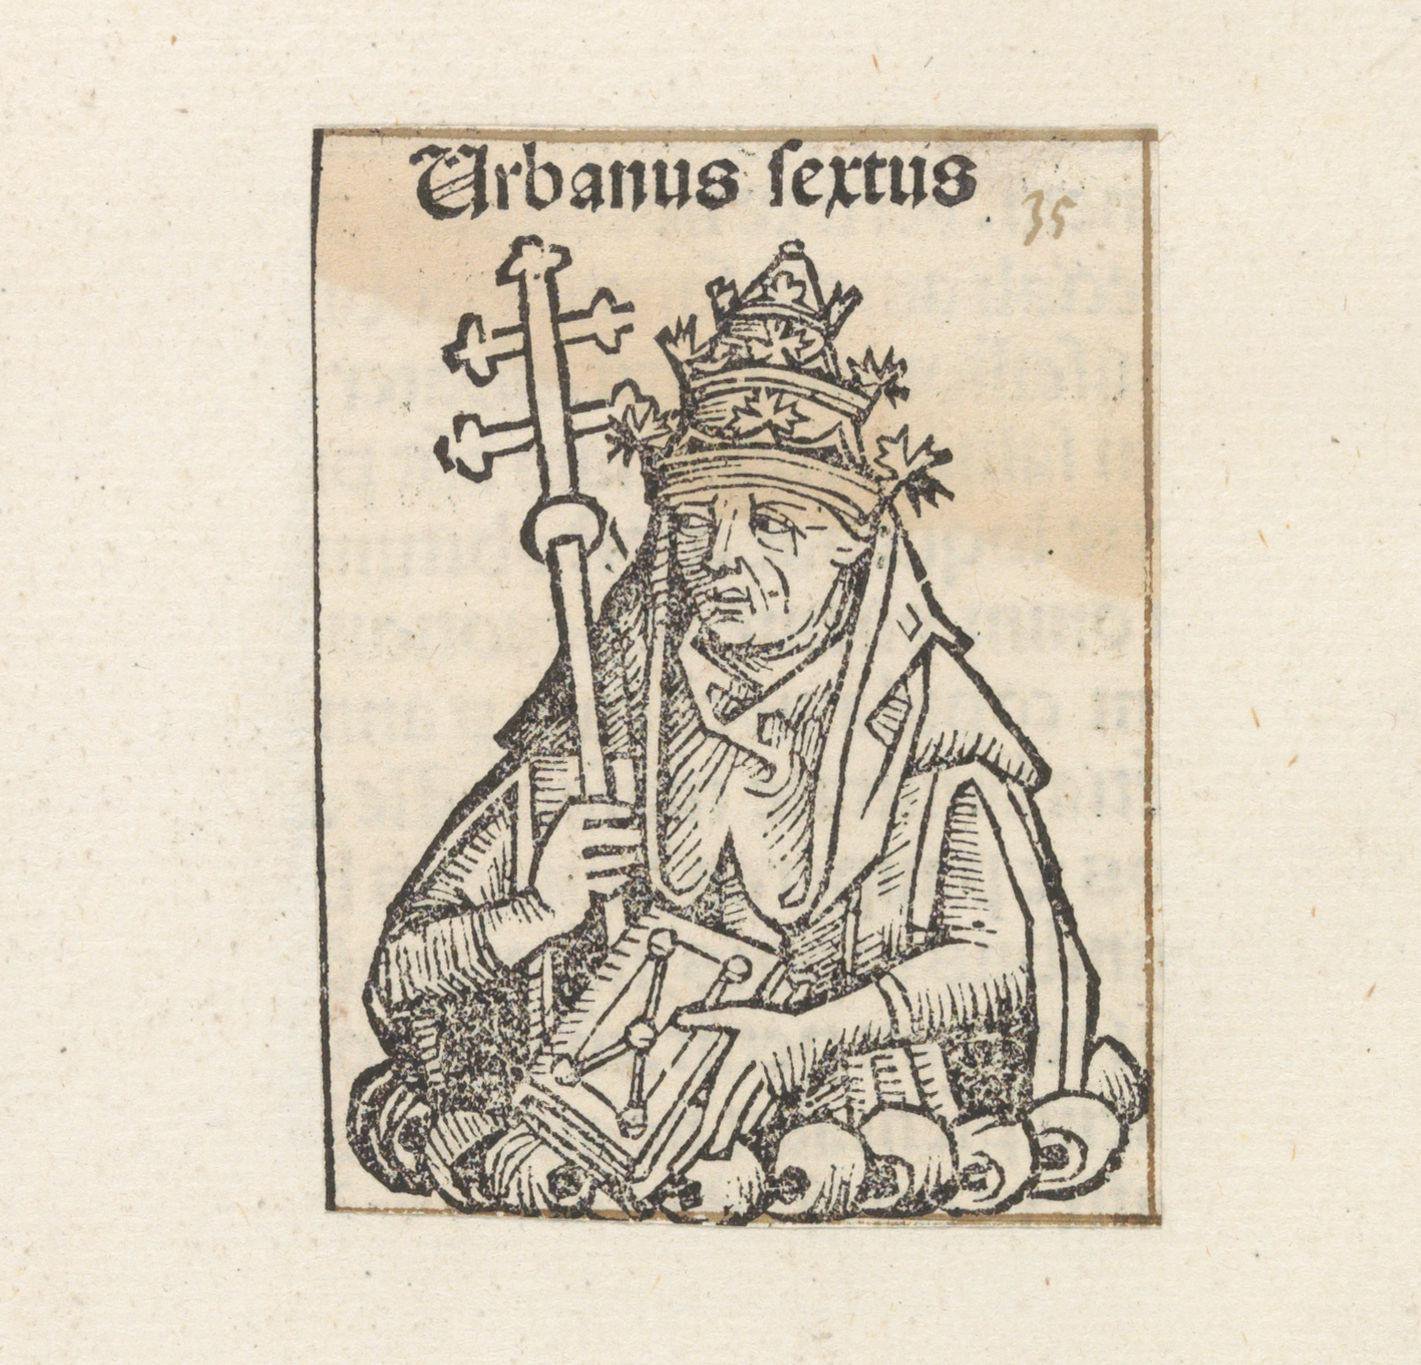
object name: album leaf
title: Urbanus der sechst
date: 1493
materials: paper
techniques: letterpress printing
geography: nuremberg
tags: naples, rome, pope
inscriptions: inscription: ‘35’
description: Een bloemkelk met een paus. Hij draagt een tiara en heeft een bijbel en staf met een dubbel kruis in zijn handen. De voorstelling is onderdeel van de opeenvolging pausen in de Liber Chronicarum. De tekst identificeert de man als Urbanus VI. De prent maakt deel uit van een album.